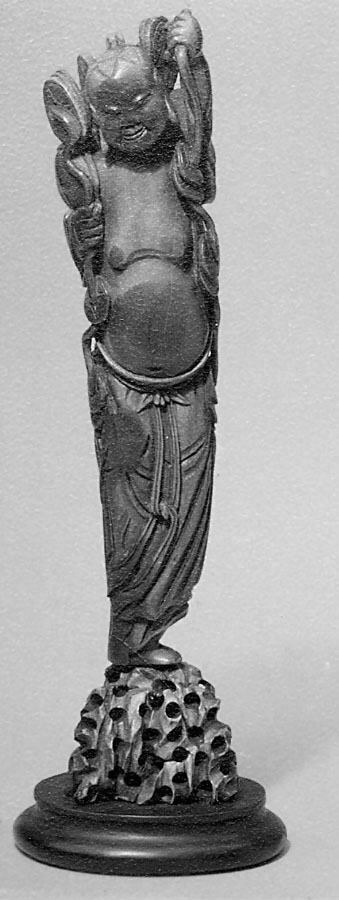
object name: statuette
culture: chinese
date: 1701-1733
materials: ivory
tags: men